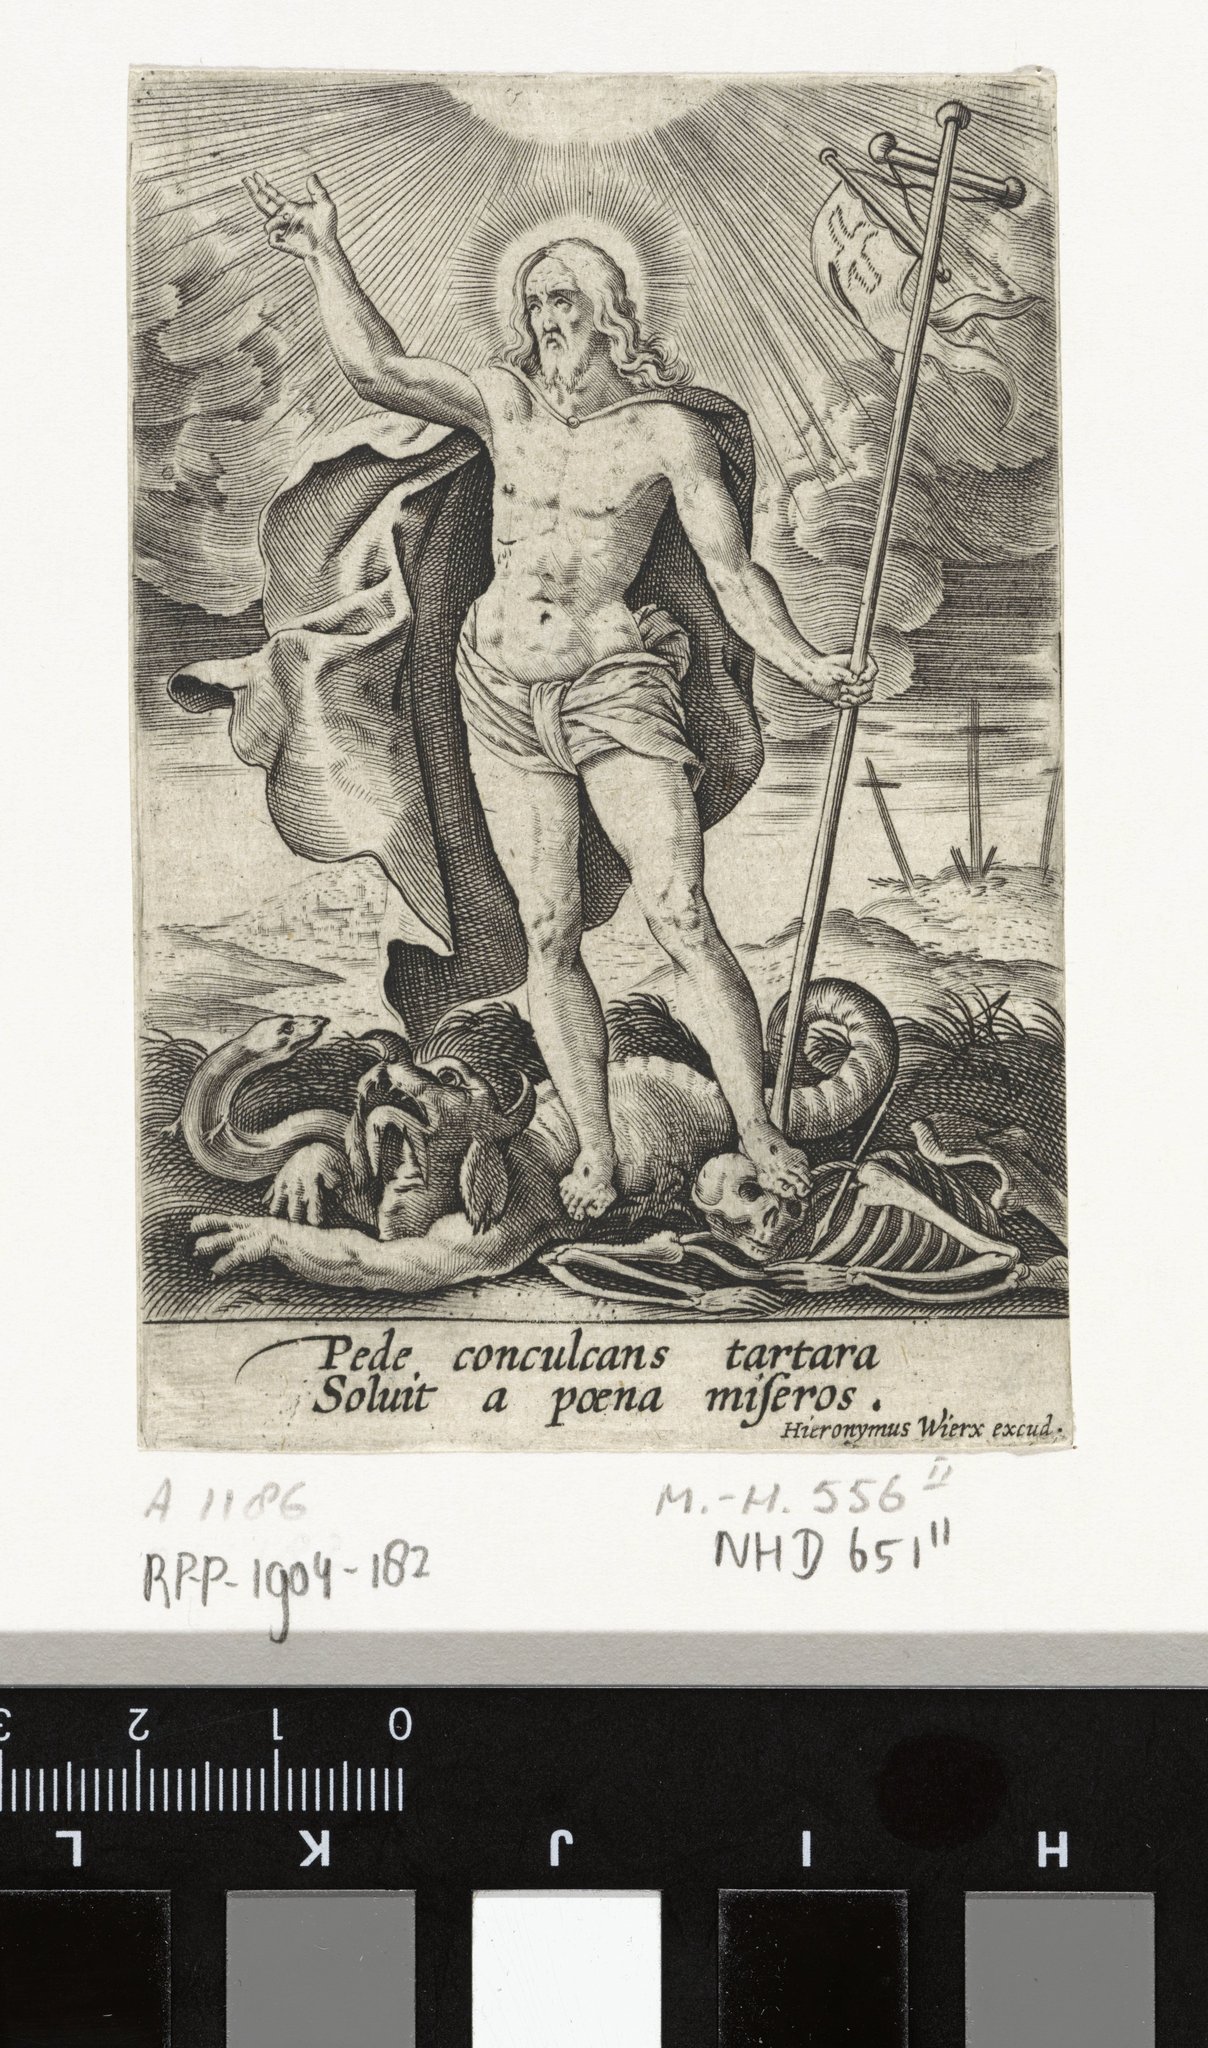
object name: print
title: Christus als overwinnaar van het kwaad en de dood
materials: paper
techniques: engraving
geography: antwerp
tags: death as skeleton, vice, evil, sin; 'peccato' (ripa), the empty cross(es), christ triumphing (with crown, head usually upright)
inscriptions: collector's mark: Lugt 2228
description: De herrezen Christus triomfeert over het kwaad en de dood. Hij vertrapt een monster en een skelet. Rechts op de achtergrond de drie lege kruizen. In de marge een tweeregelig onderschrift in het Latijn.